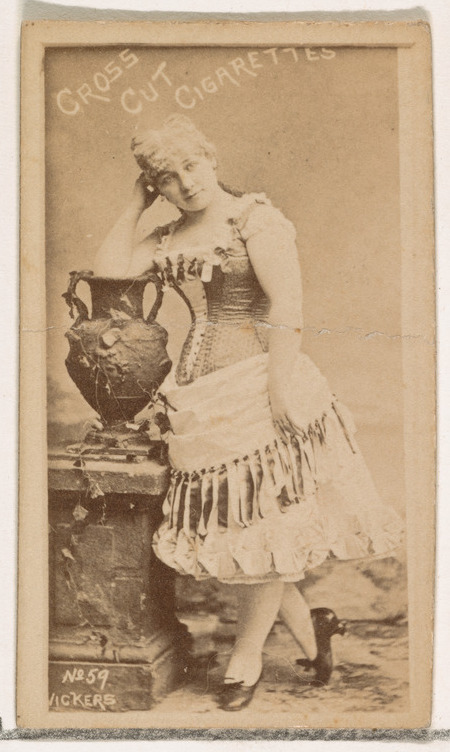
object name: print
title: Card Number 59, Vickers, from the Actors and Actresses series (N145-1) issued by Duke Sons & Co. to promote Cross Cut Cigarettes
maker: w. duke, sons & co.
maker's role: publisher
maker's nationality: american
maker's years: 1870-1920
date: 1880-1889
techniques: albumen silver print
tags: portraits,women,actresses